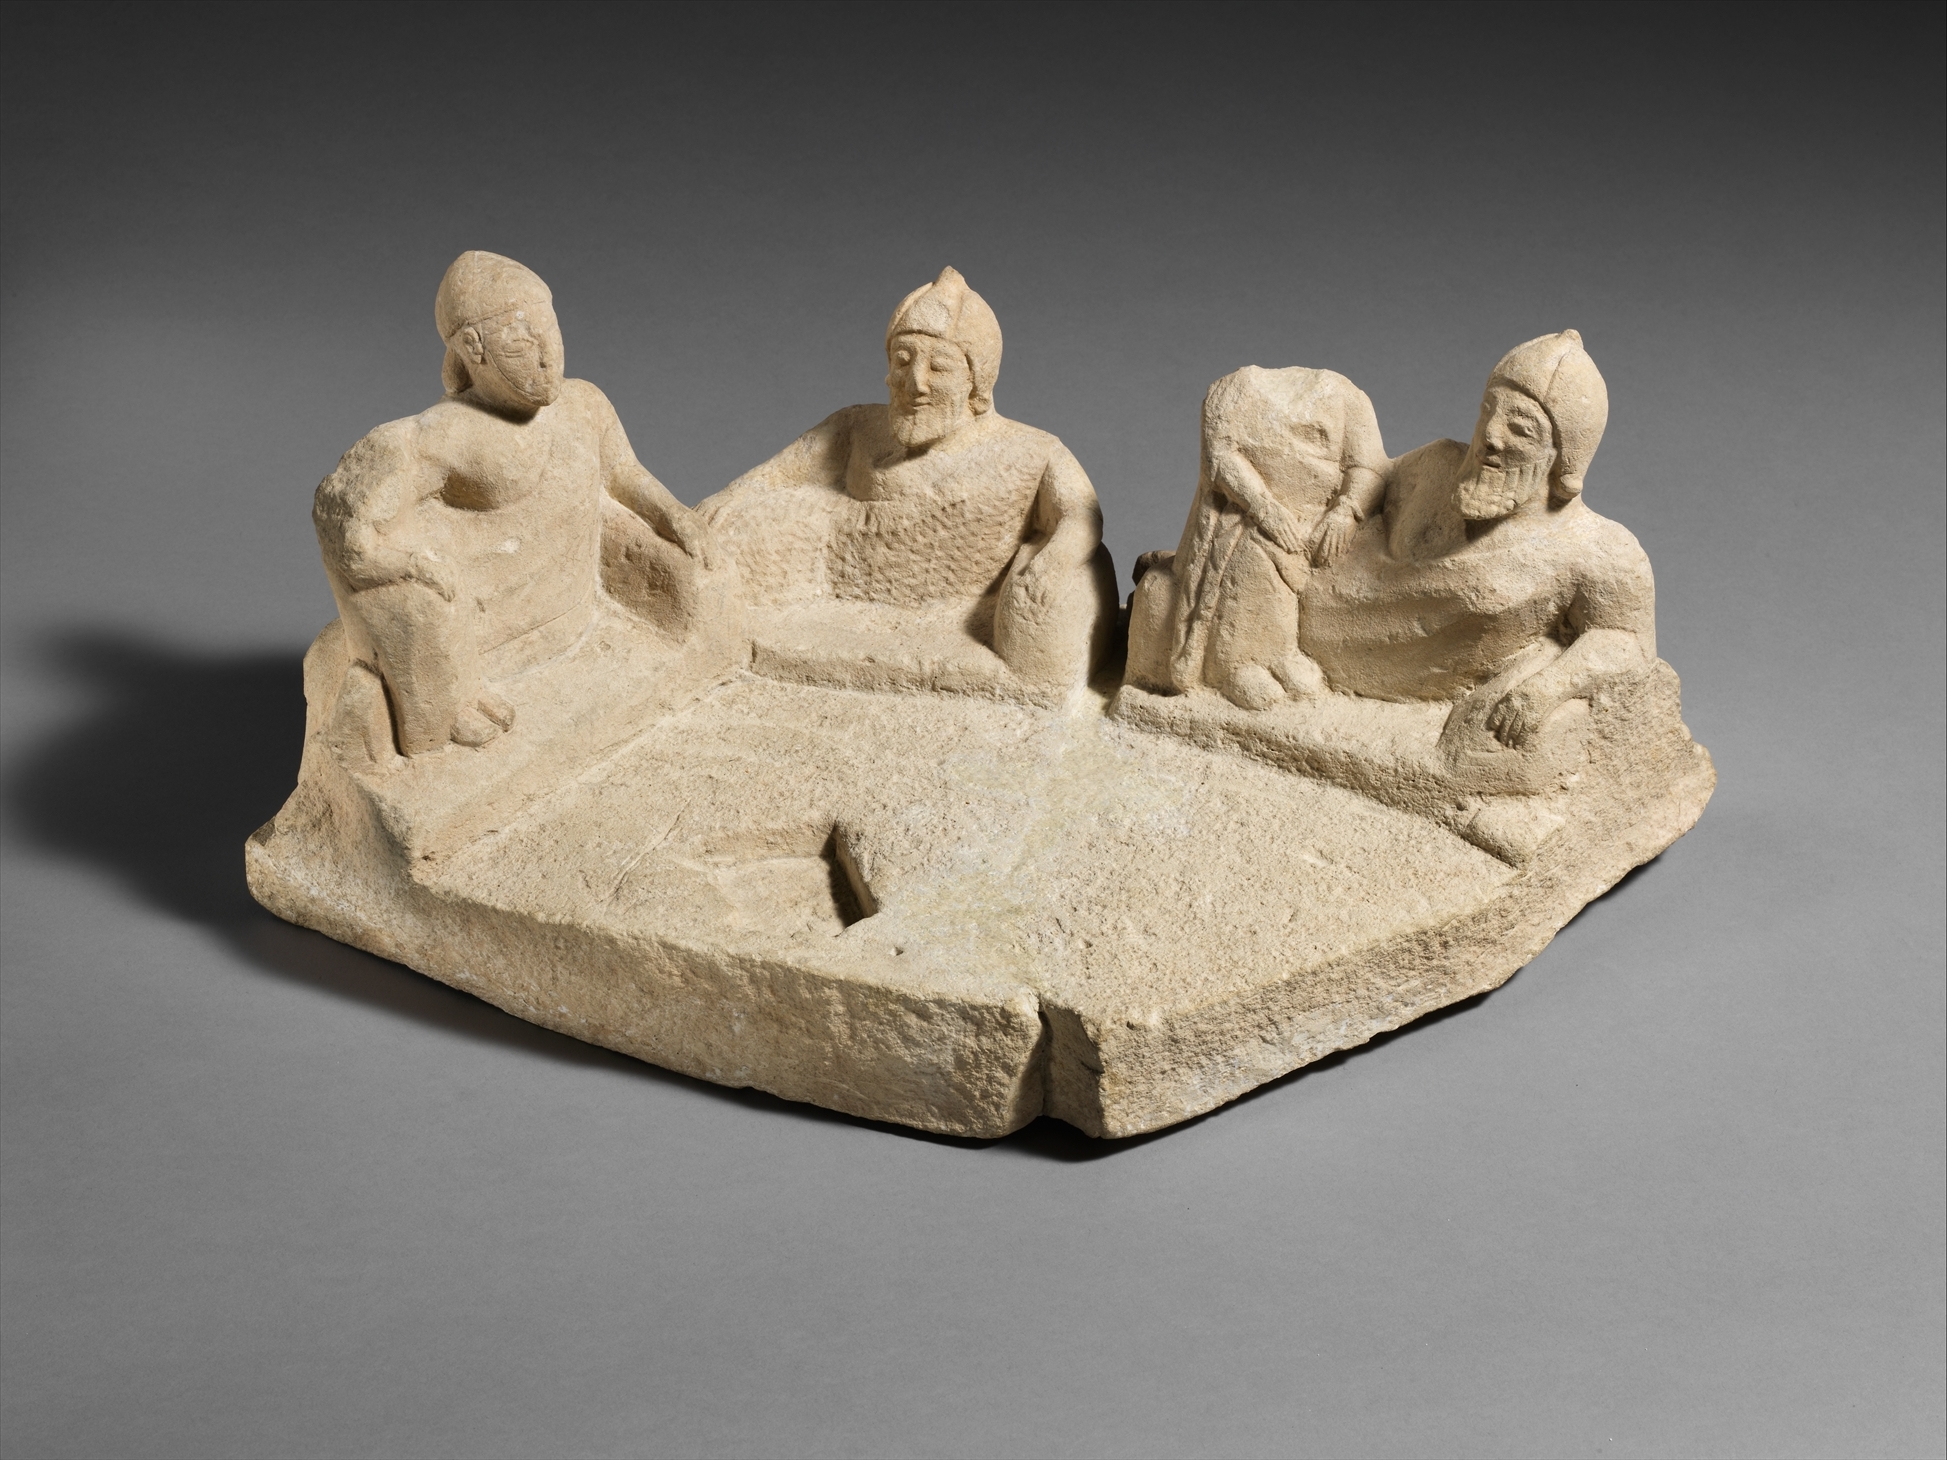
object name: banquet scene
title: Limestone group: banquet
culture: cypriot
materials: limestone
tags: men,women